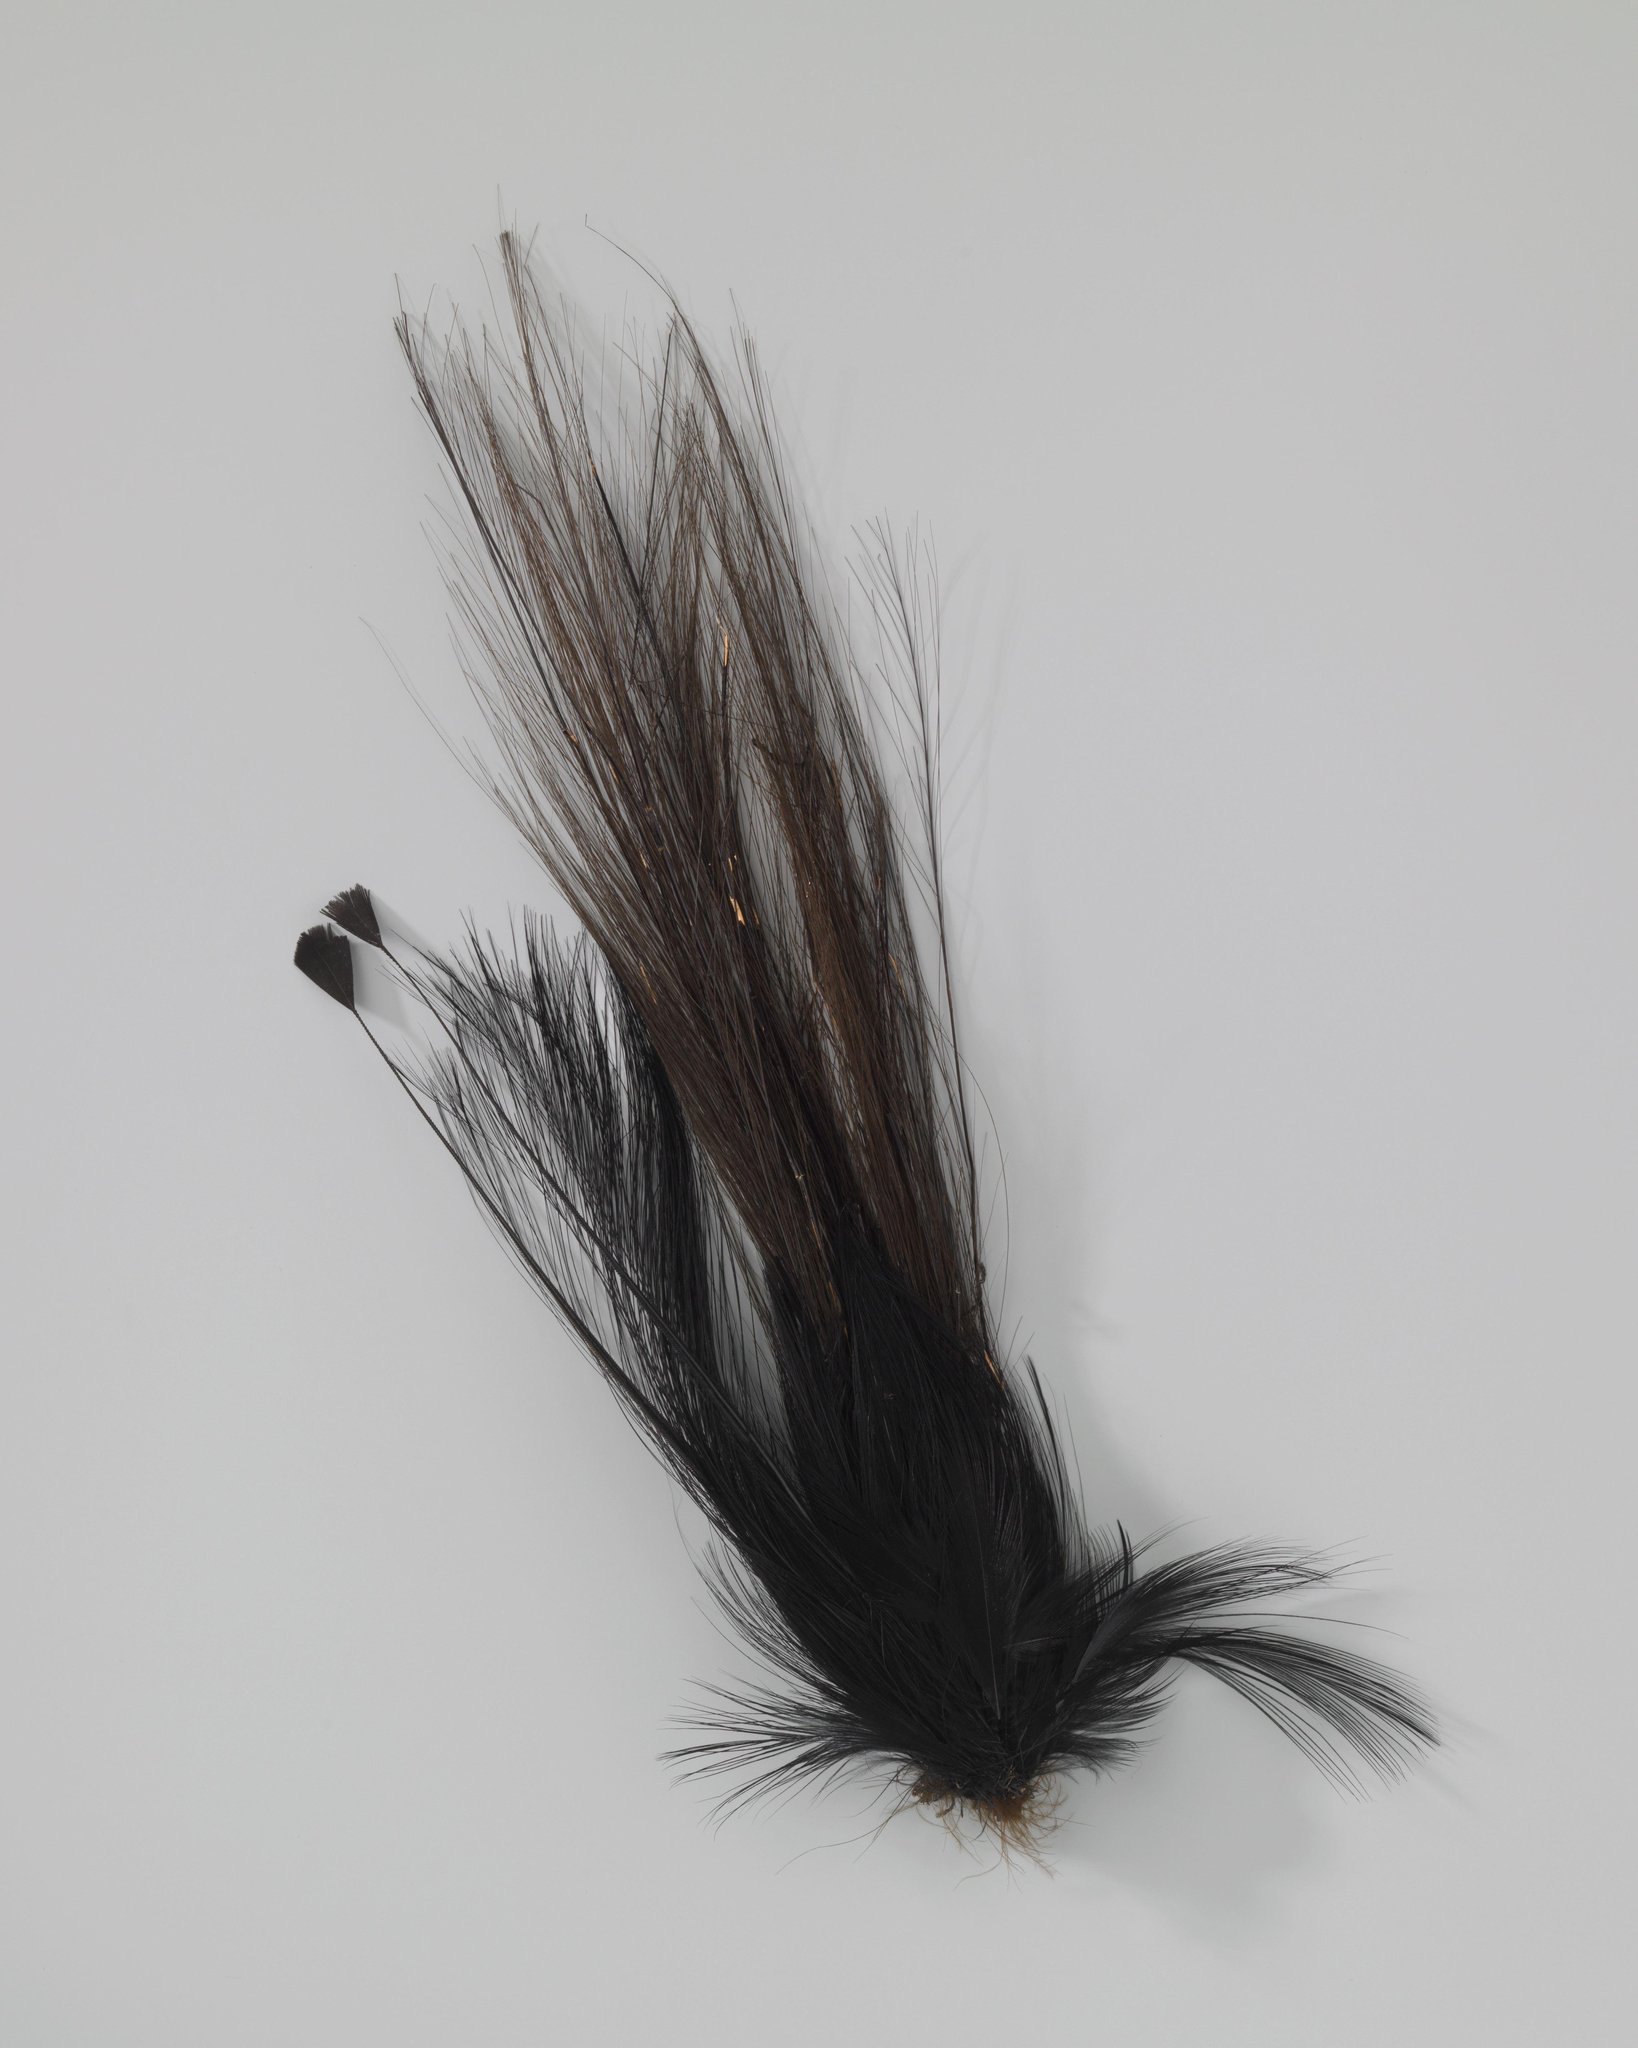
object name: womenswear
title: Aigrette met een foef van gladde reigerveren als kroon, zwart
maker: Anonymous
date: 1900-1915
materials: feather, metal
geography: europe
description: Aigrette met een foef van gladde reigerveren als kroon, zwart. Twee van de veren hebben een kleine kwast.